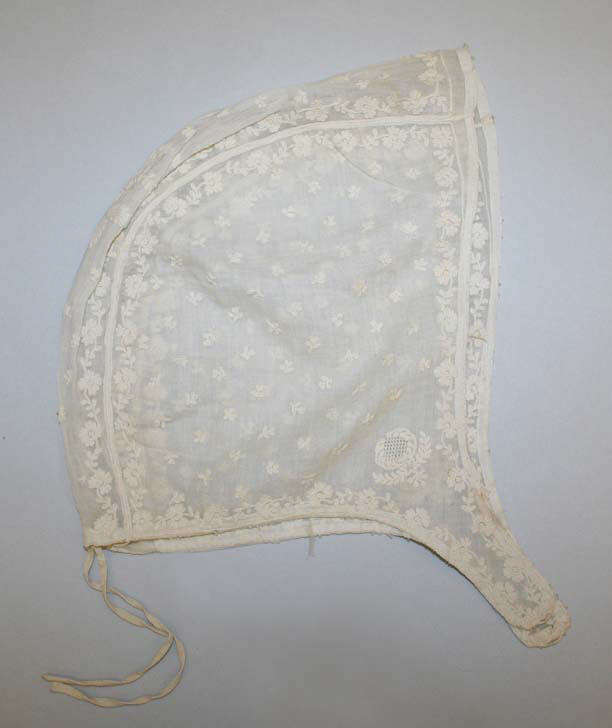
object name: cap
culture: british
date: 1801-1900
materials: cotton